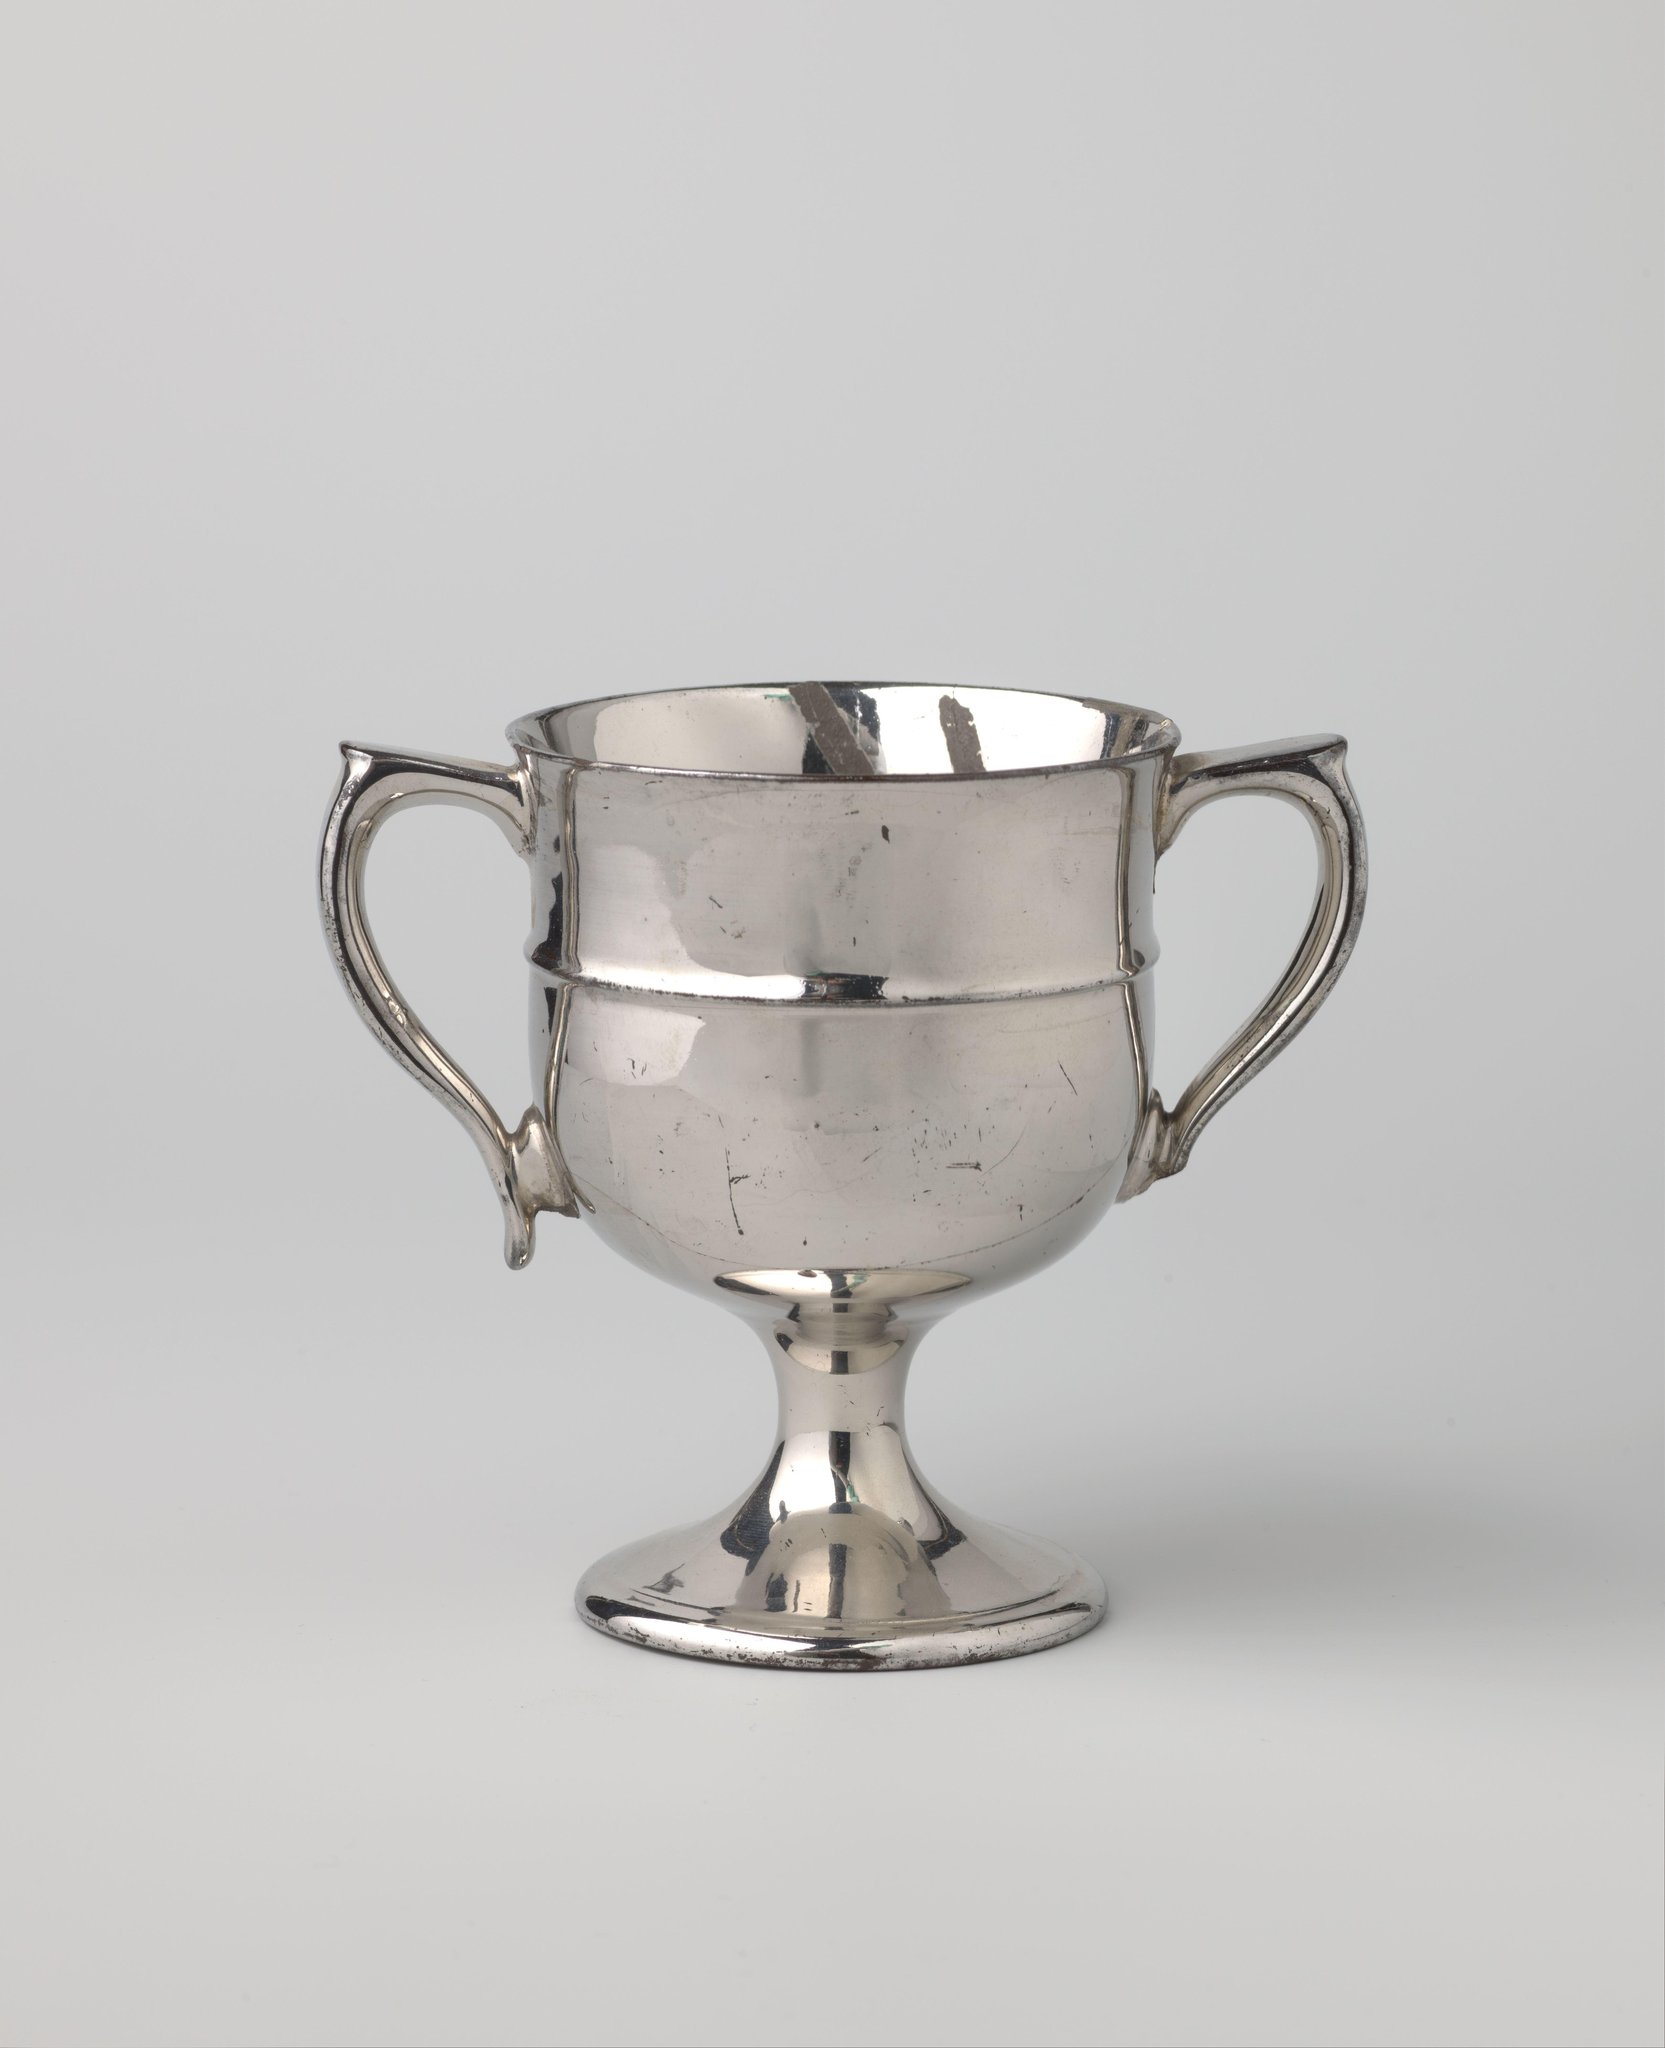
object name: goblet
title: Bokaal van roodbruin hardgebakken aardewerk met zilverluster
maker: Anonymous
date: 1810-1840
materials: earthenware, silver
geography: england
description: Bokaal van roodbruin hardgebakken aardewerk, met een zilverluster gedekt. De halfbolvormige bokaal gaat over in een gewelfde voet. De bokaal heeft twee oren.